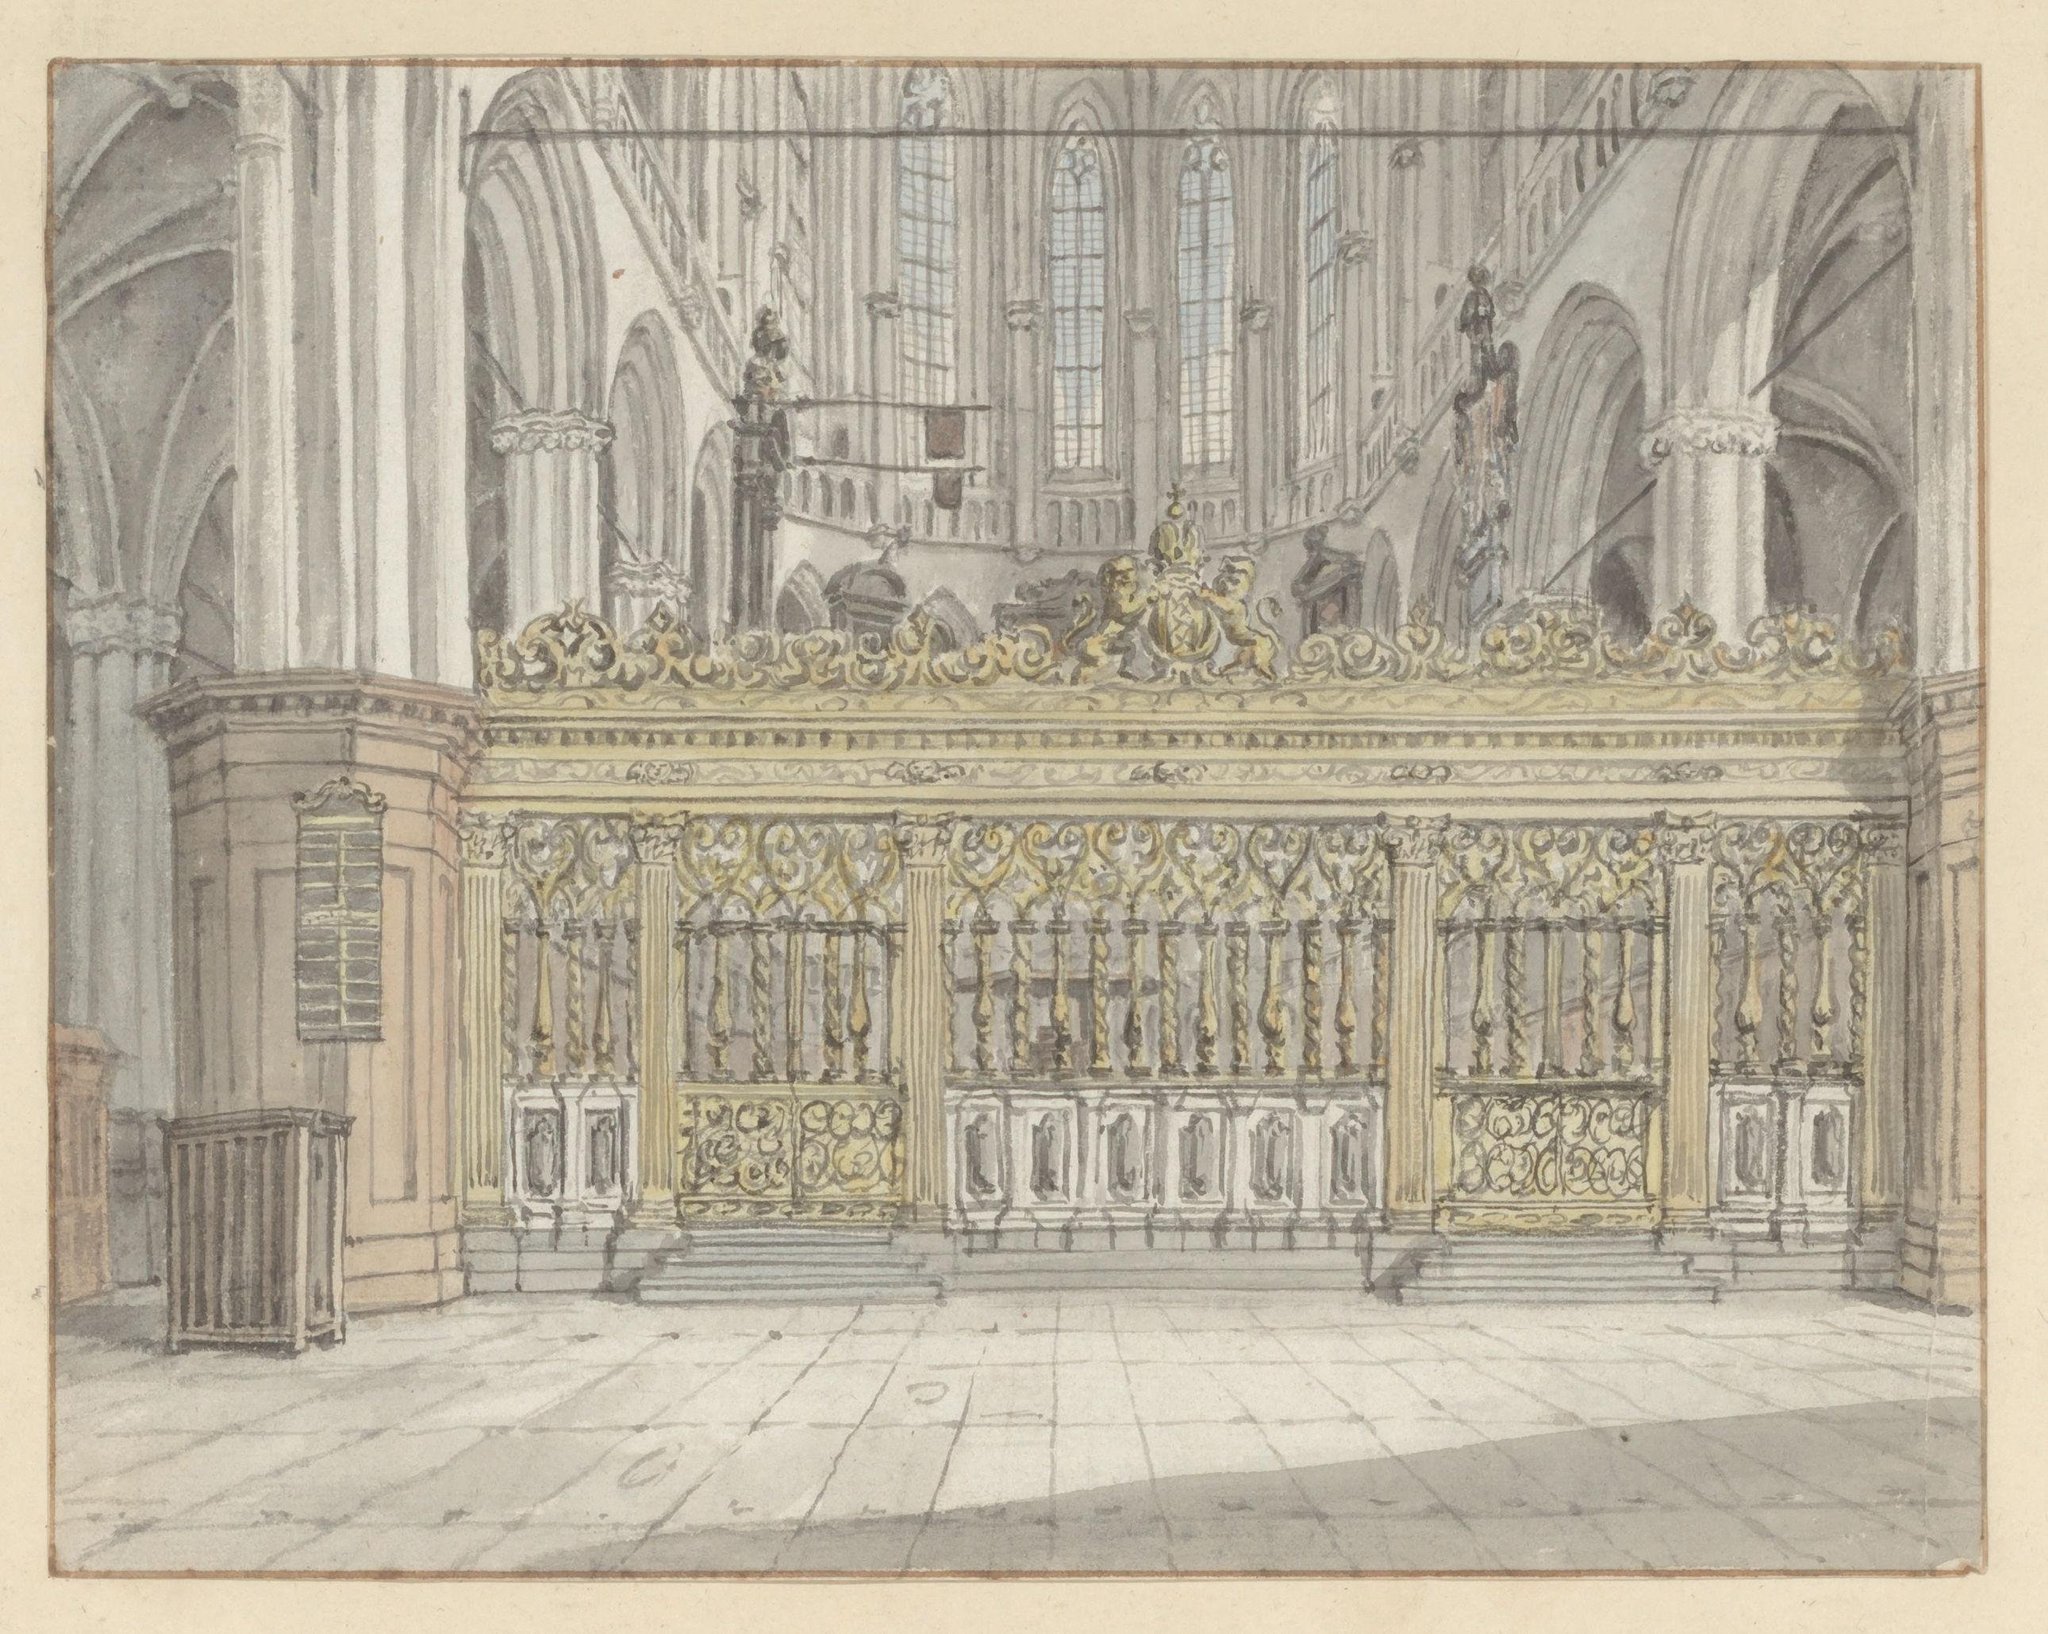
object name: drawing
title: Interieur van de Nieuwe Kerk gezien naar het koorhek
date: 1786-1850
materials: ink, paper, pencil, watercolor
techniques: brush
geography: amsterdam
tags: interior of church, parts of church interior: choir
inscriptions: collector's mark: Lugt 800a, inscription: ‘Gezigt in de Nieuwe Kerk / Ziende op het Choor’, signature: ‘H P. Schouten del. / G Lamberts term.’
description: Tekening binnen de Atlas Van Eck ingedeeld op wijknummer 5.